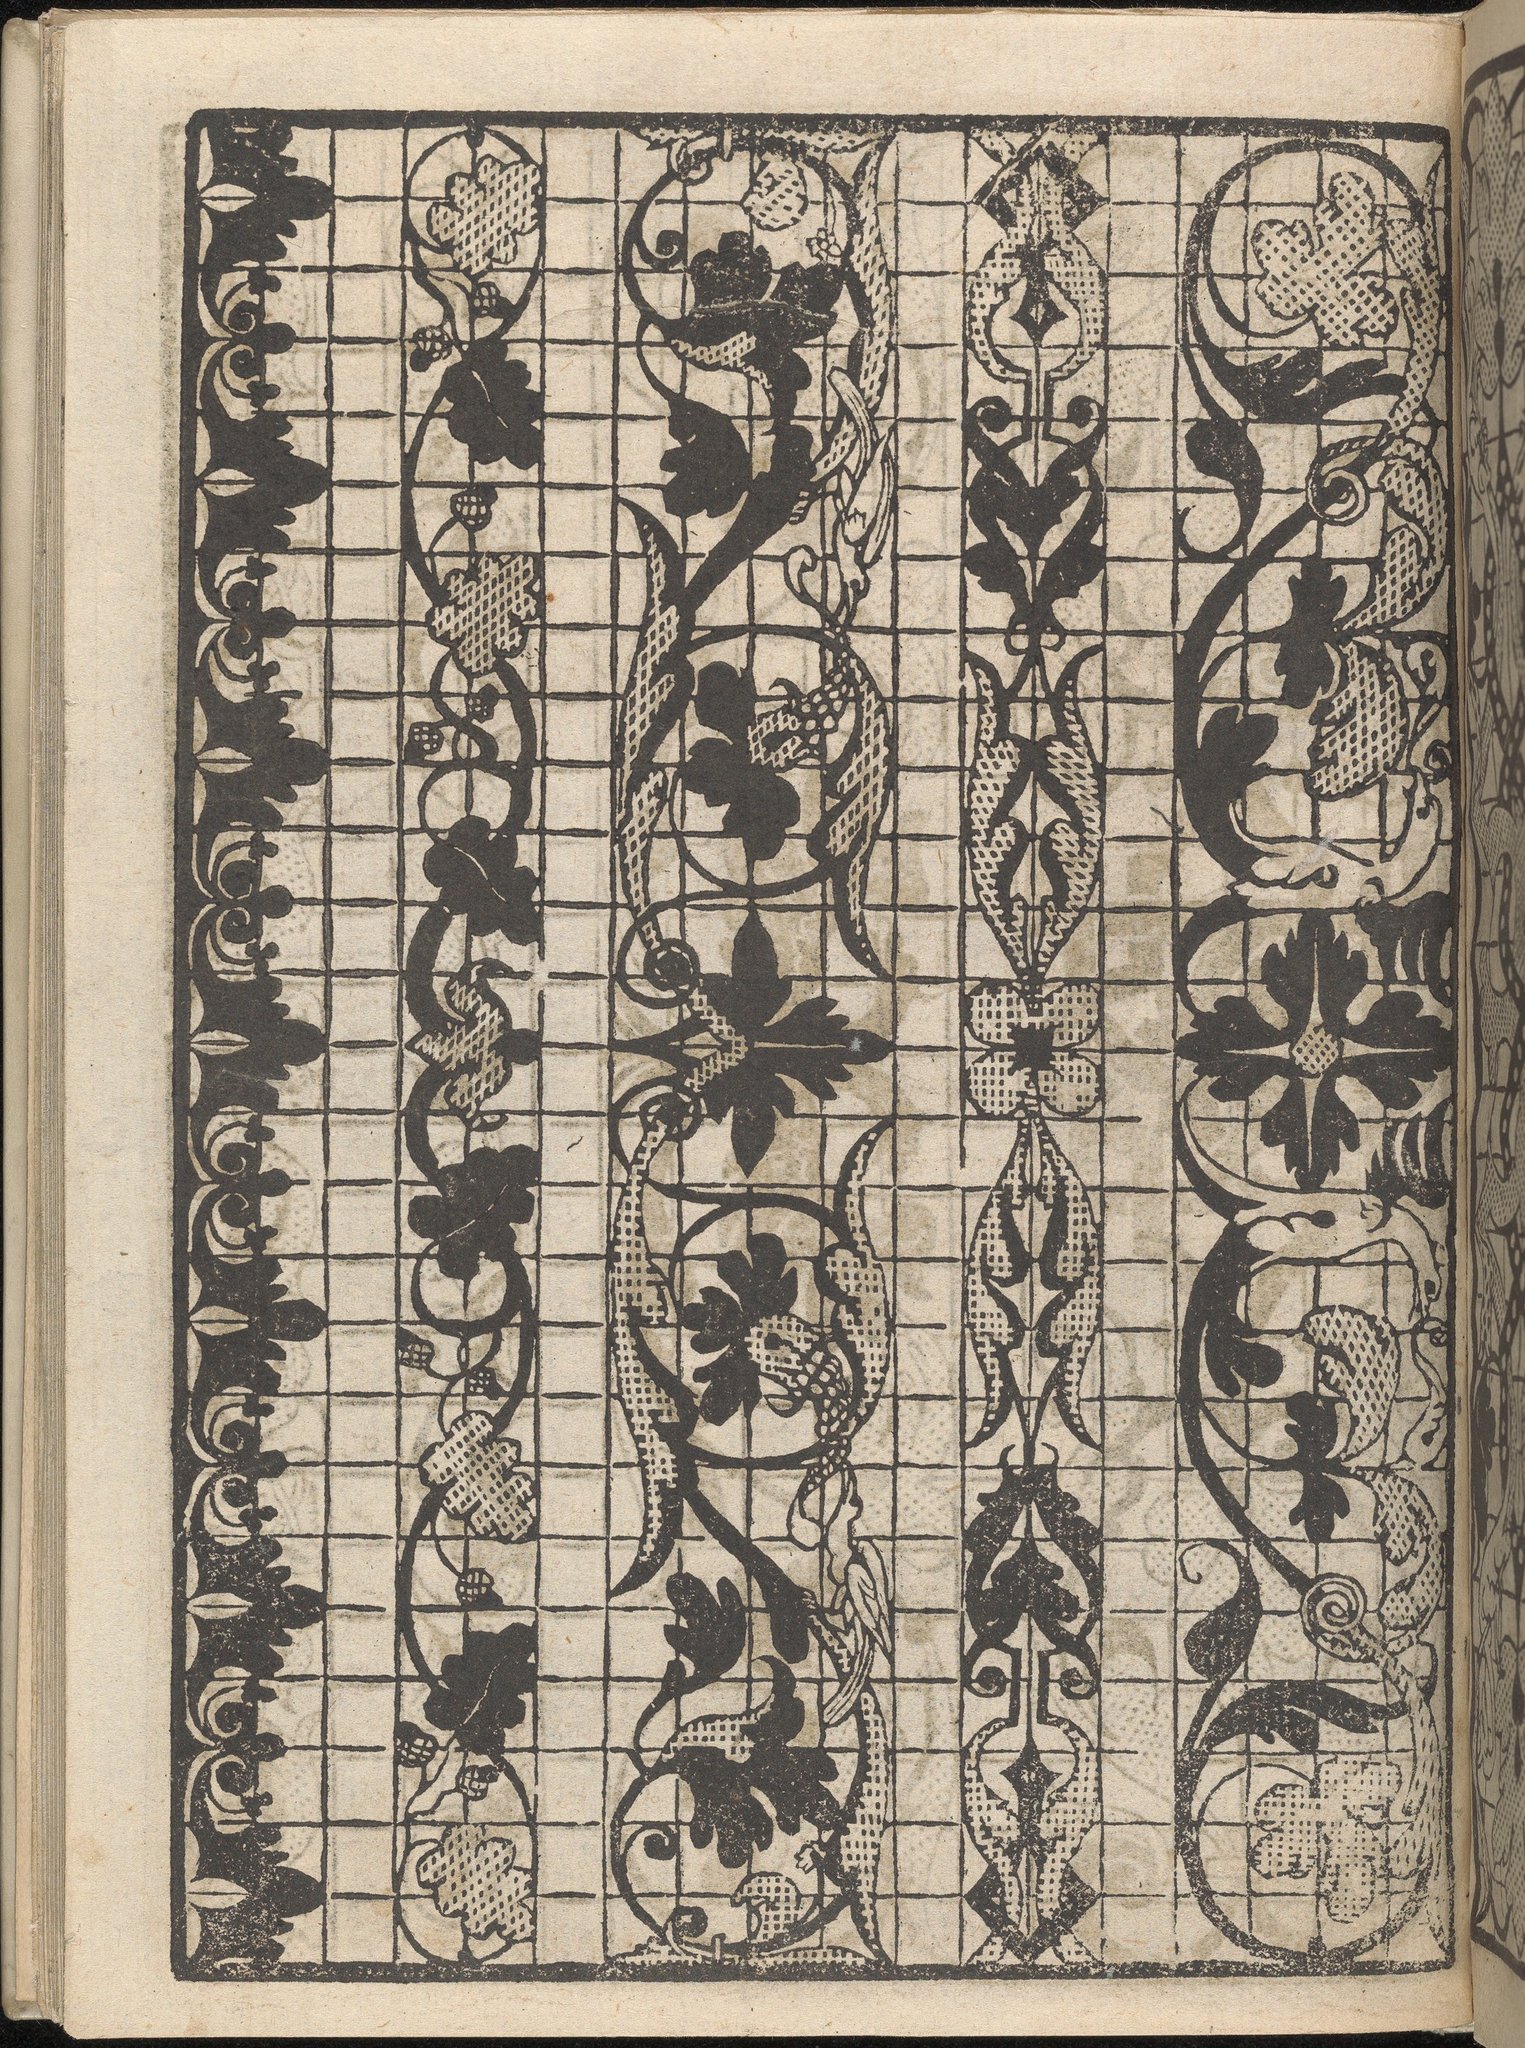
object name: book print ornament architecture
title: Splendore delle virtuose giovani, page 15 (verso)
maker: iseppo foresto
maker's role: designer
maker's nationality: italian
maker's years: 1520-1580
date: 1564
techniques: woodcut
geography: italy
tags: birds,flowers